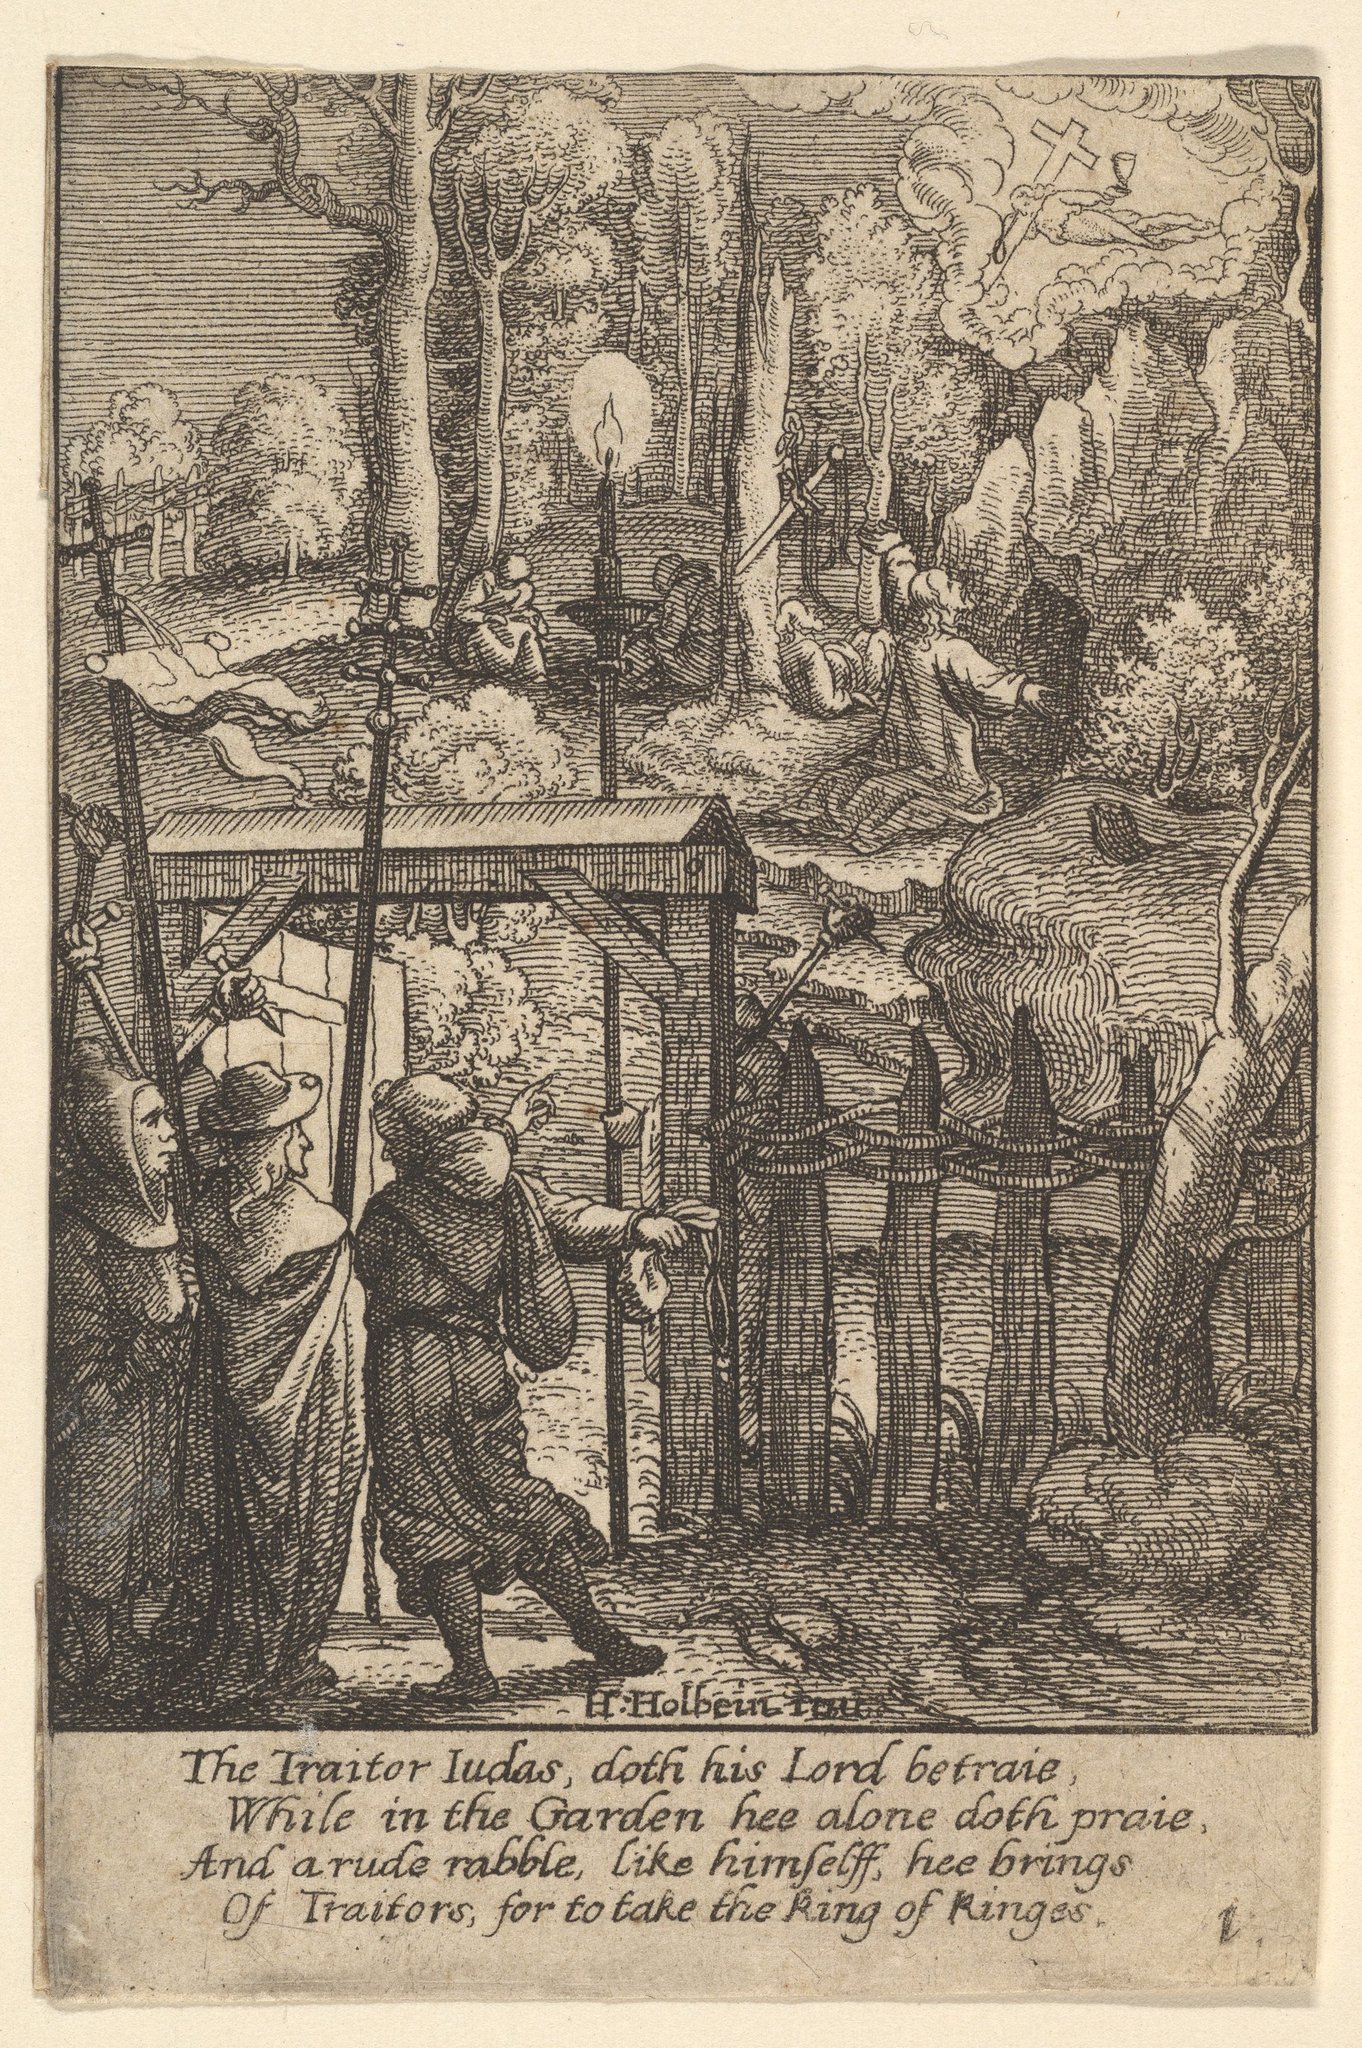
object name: print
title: Jesus on the Mount of Olives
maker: wenceslaus hollar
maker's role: artist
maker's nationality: bohemian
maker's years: 1607-1677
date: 1644-1652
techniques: etching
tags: cross,jesus